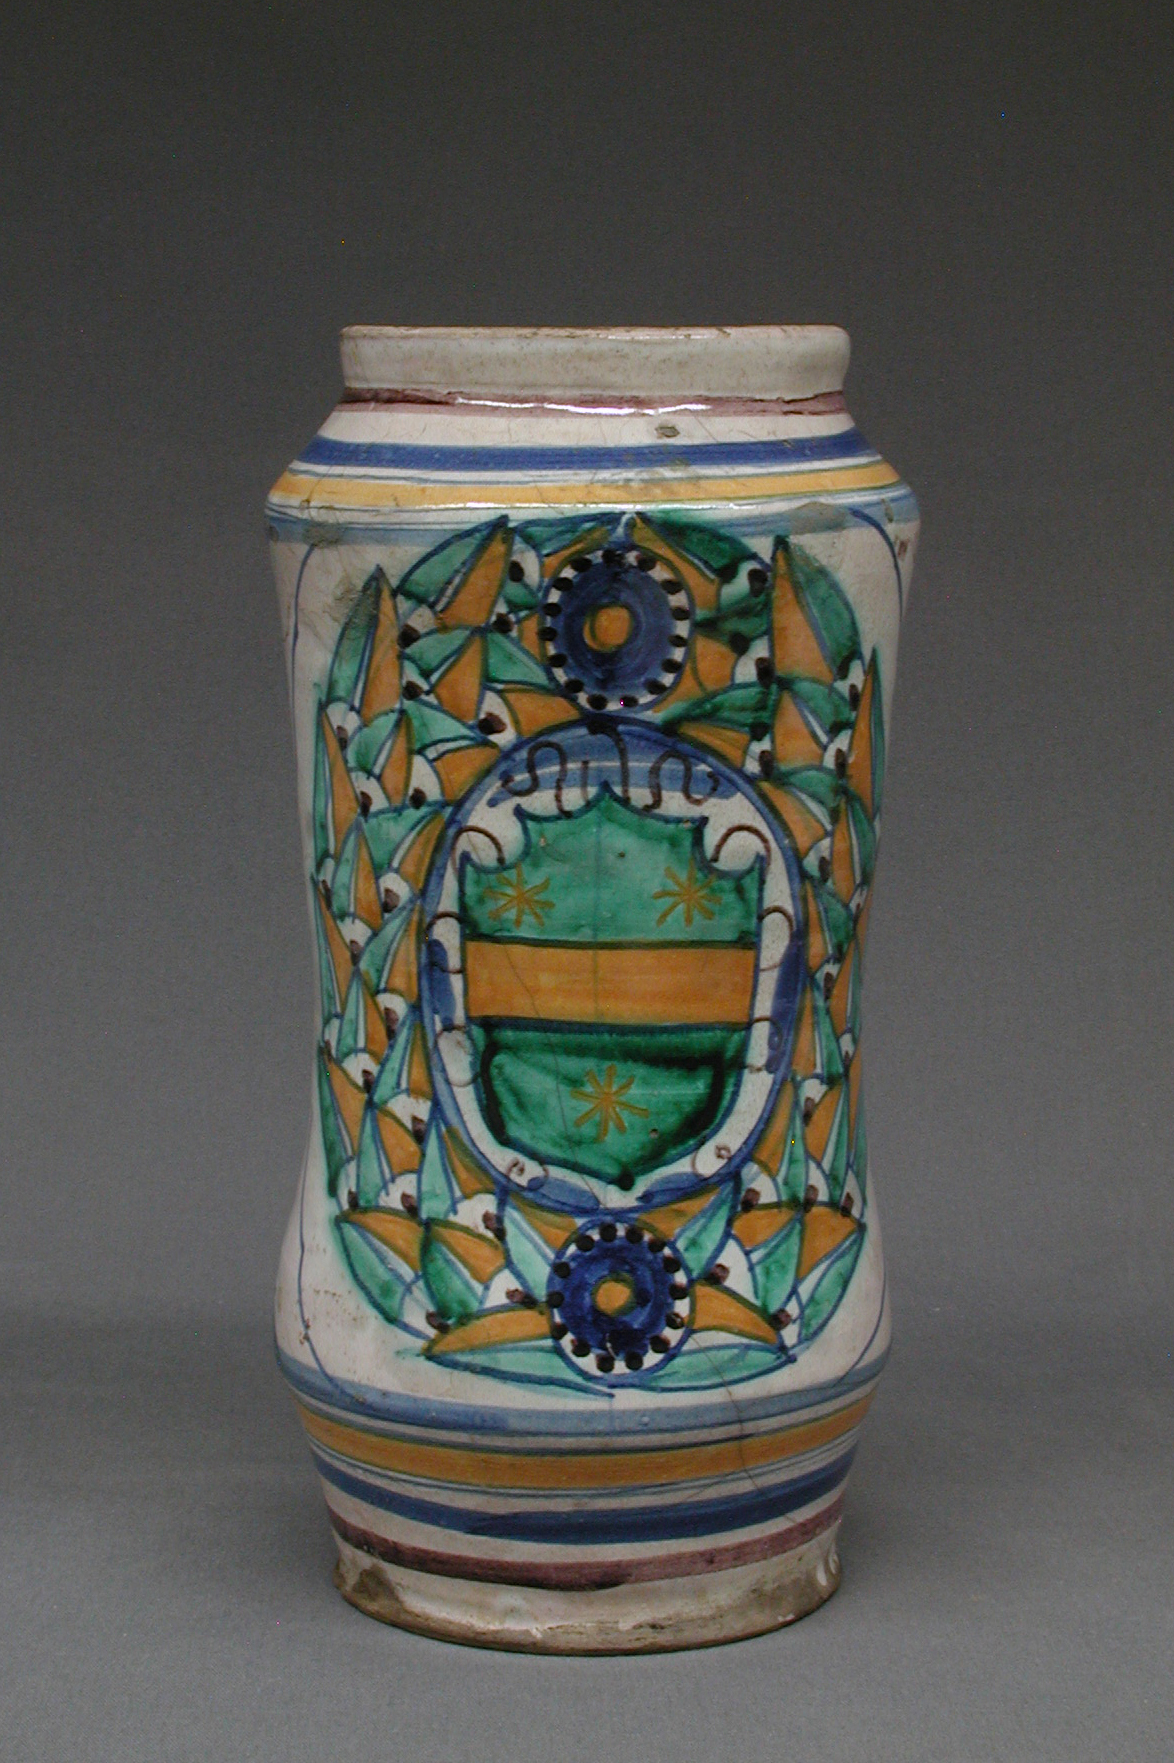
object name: albarello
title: Storage Jar (Albarello)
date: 1501-1600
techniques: maiolica, glazing